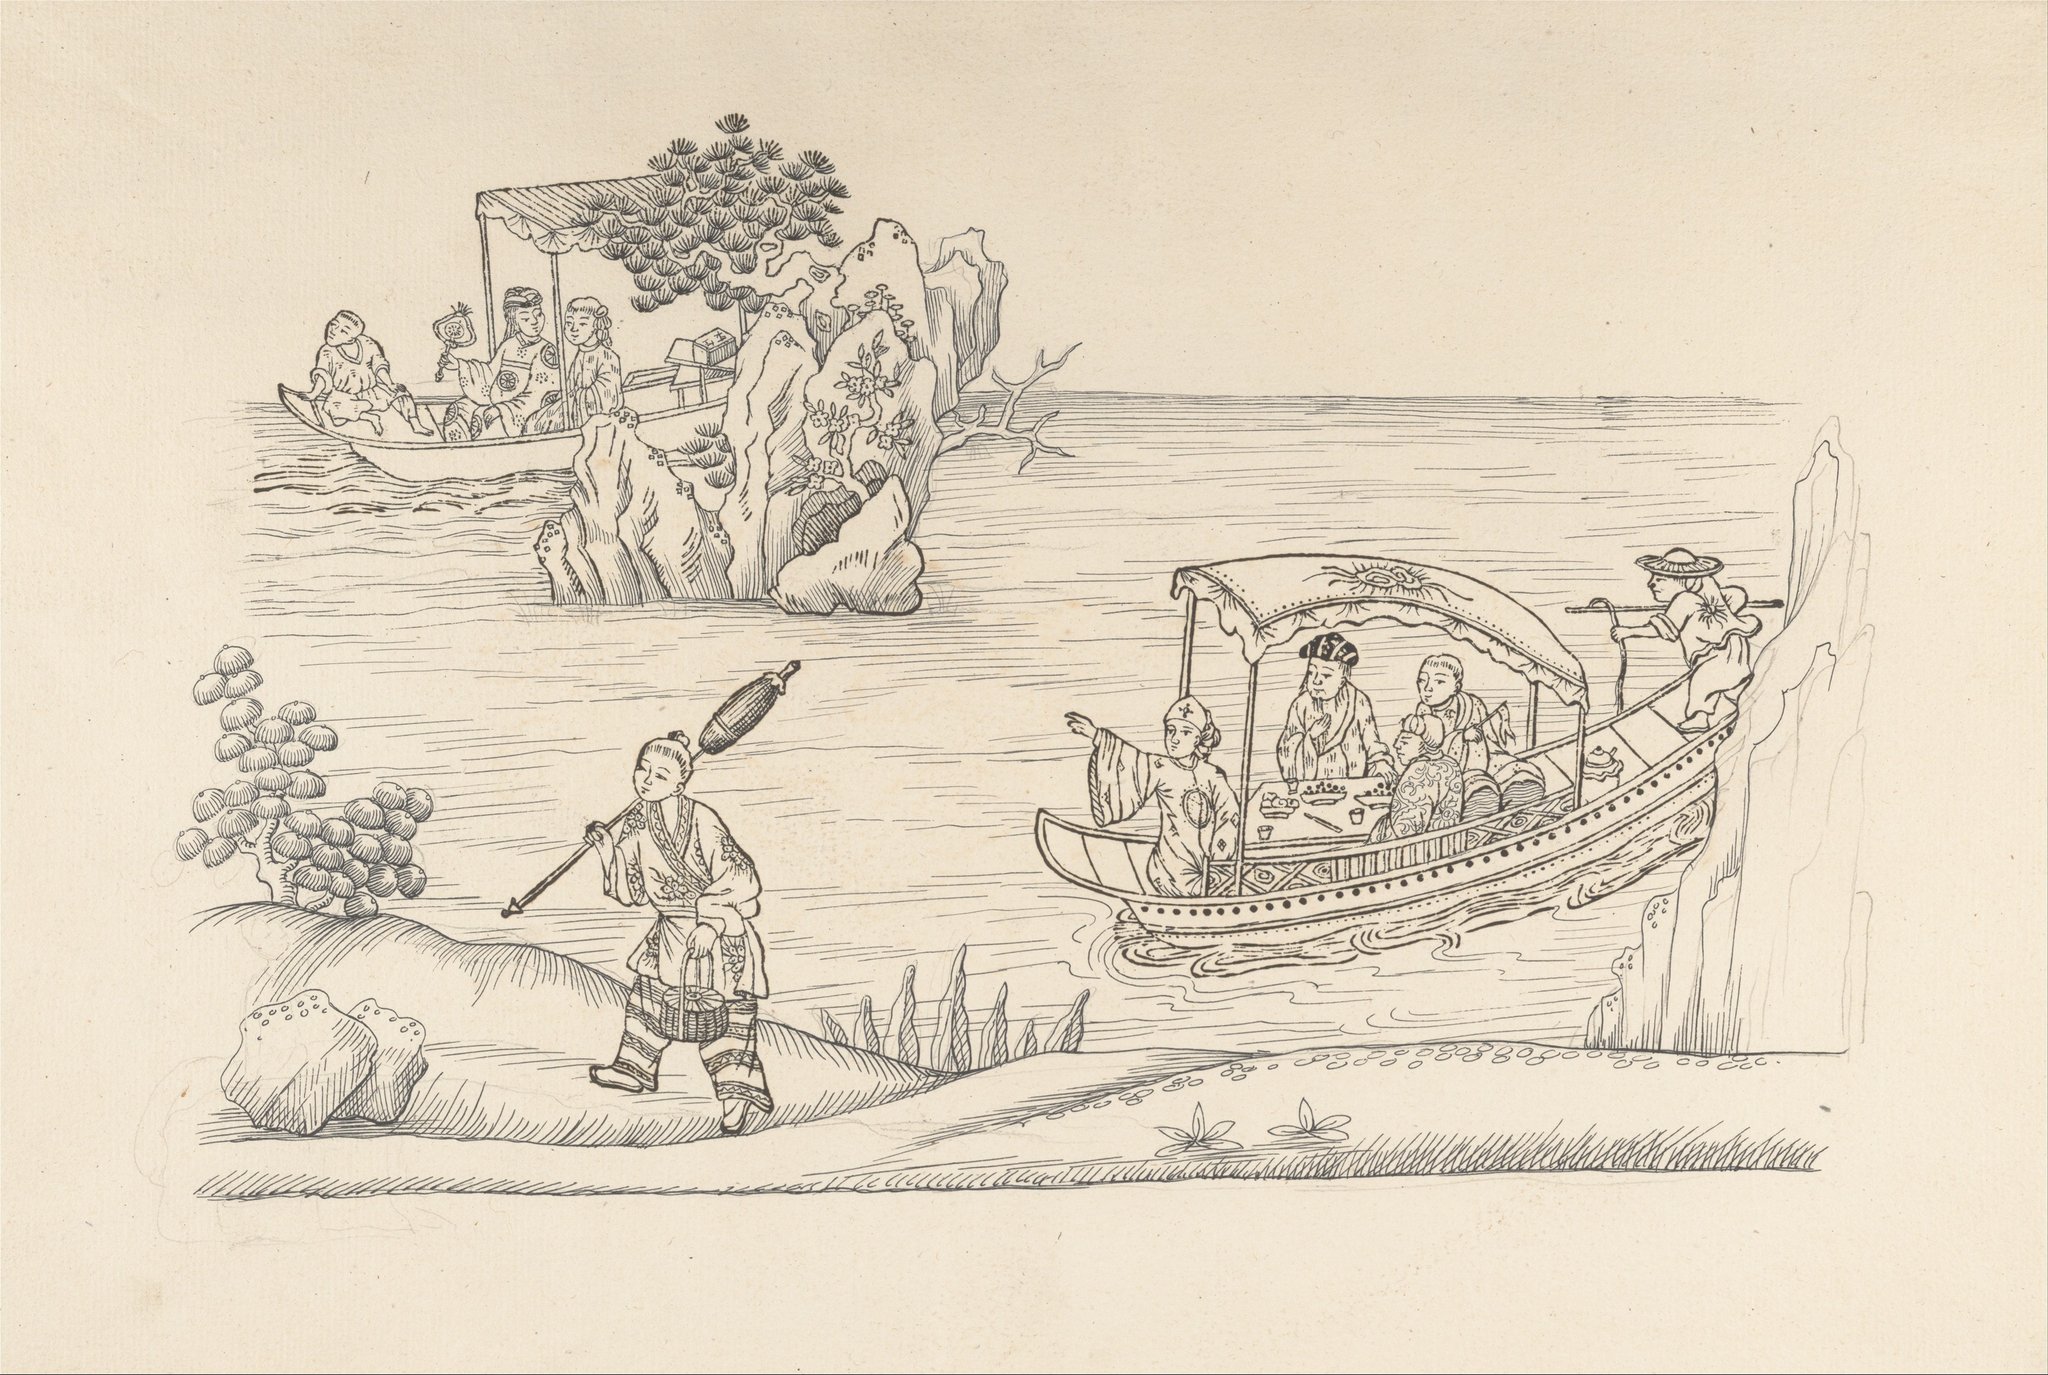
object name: book print ornament architecture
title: Book of Chinese Designs, taken from the originals of Persia, of the Indies, of China and of Japan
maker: jean antoine fraisse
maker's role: artist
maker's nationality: french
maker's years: 1680-1739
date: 1735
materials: ink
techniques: engraving, pen, woodcut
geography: france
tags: men,boats